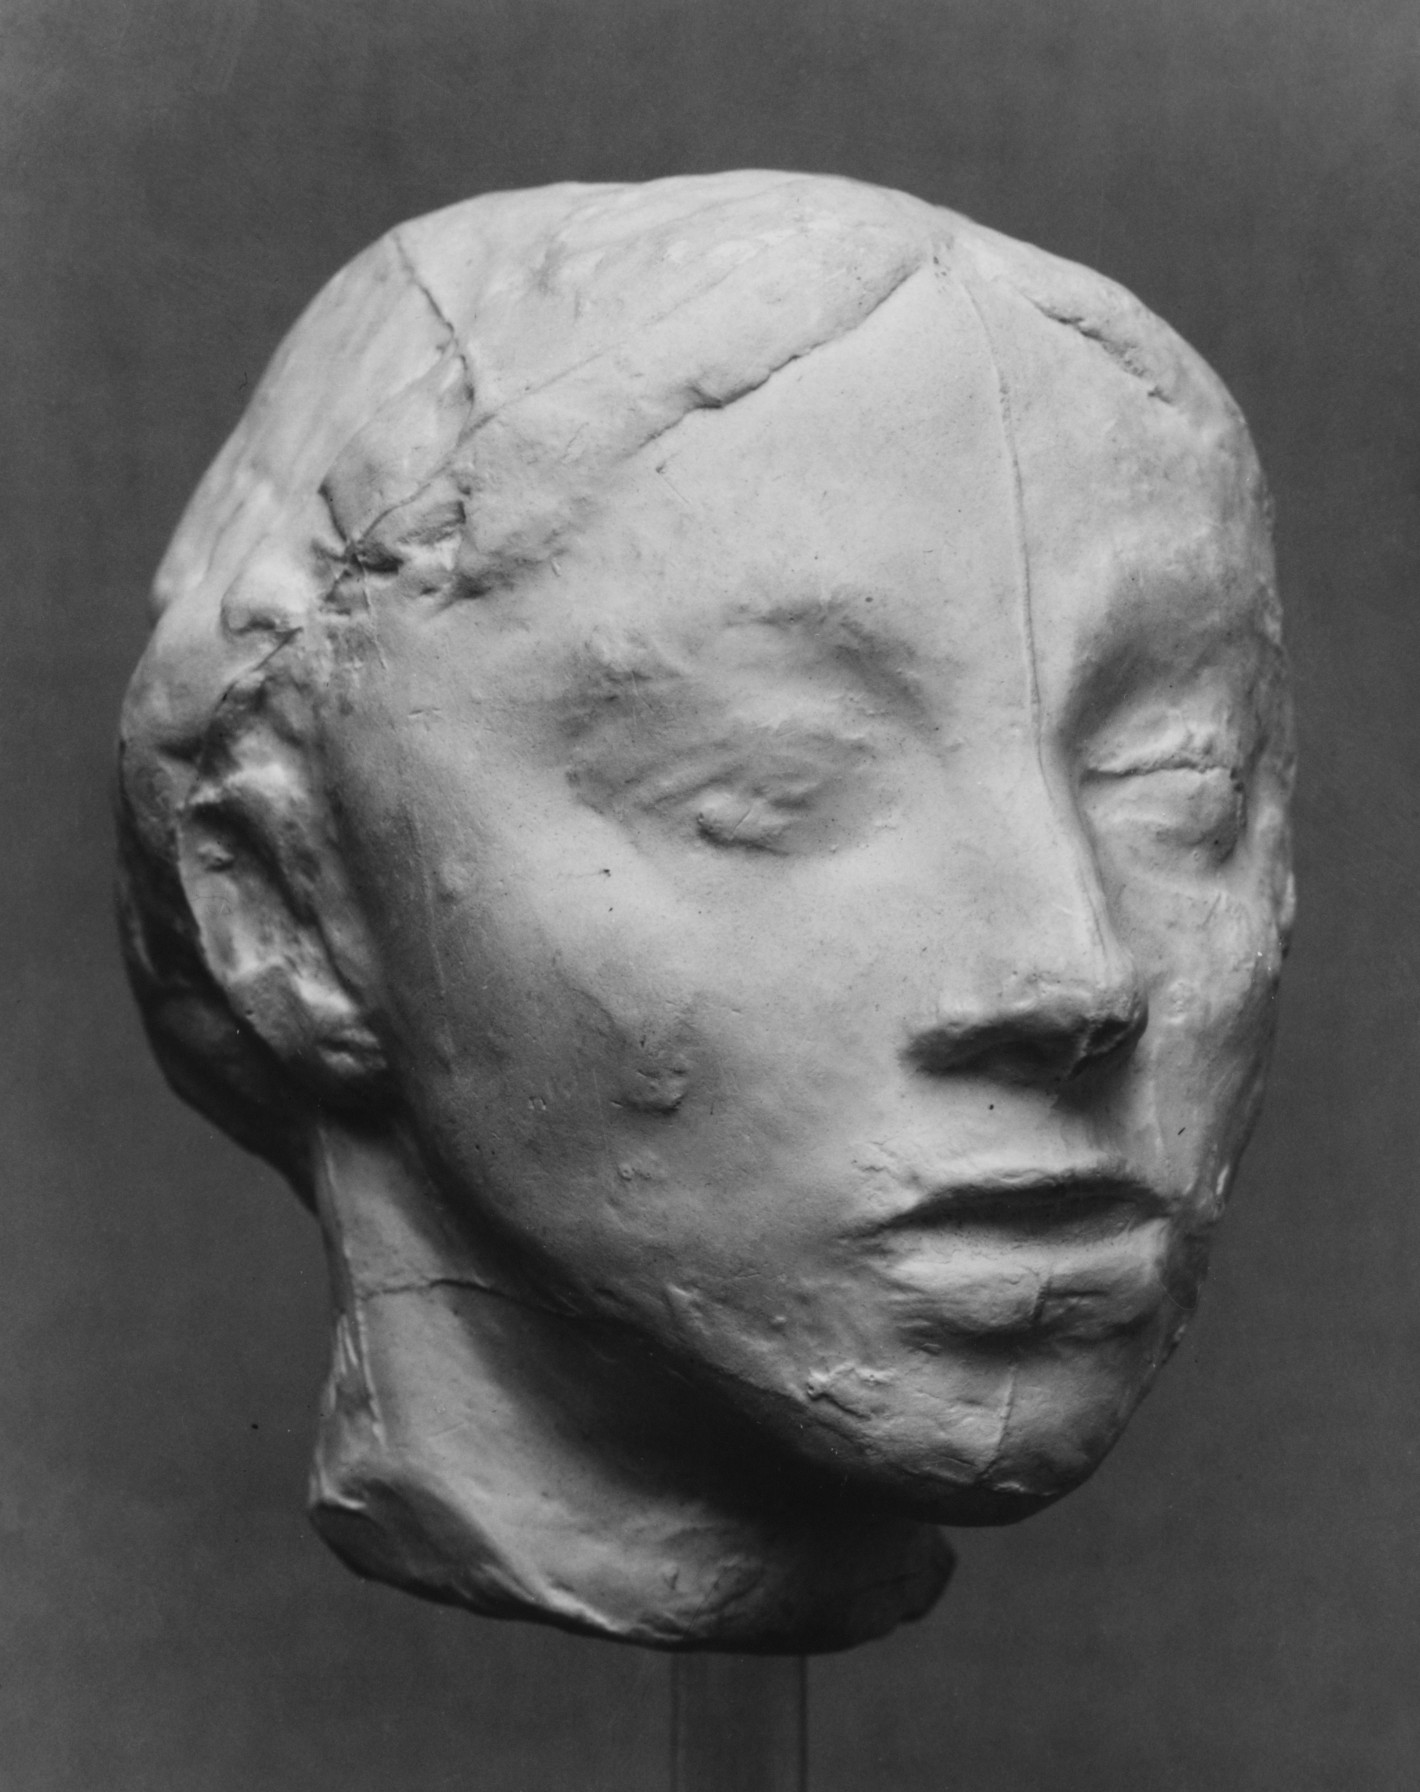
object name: head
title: Gwen John (Study for a Muse)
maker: auguste rodin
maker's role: artist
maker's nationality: french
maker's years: 1840-1917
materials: plaster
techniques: casting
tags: heads,portraits,women